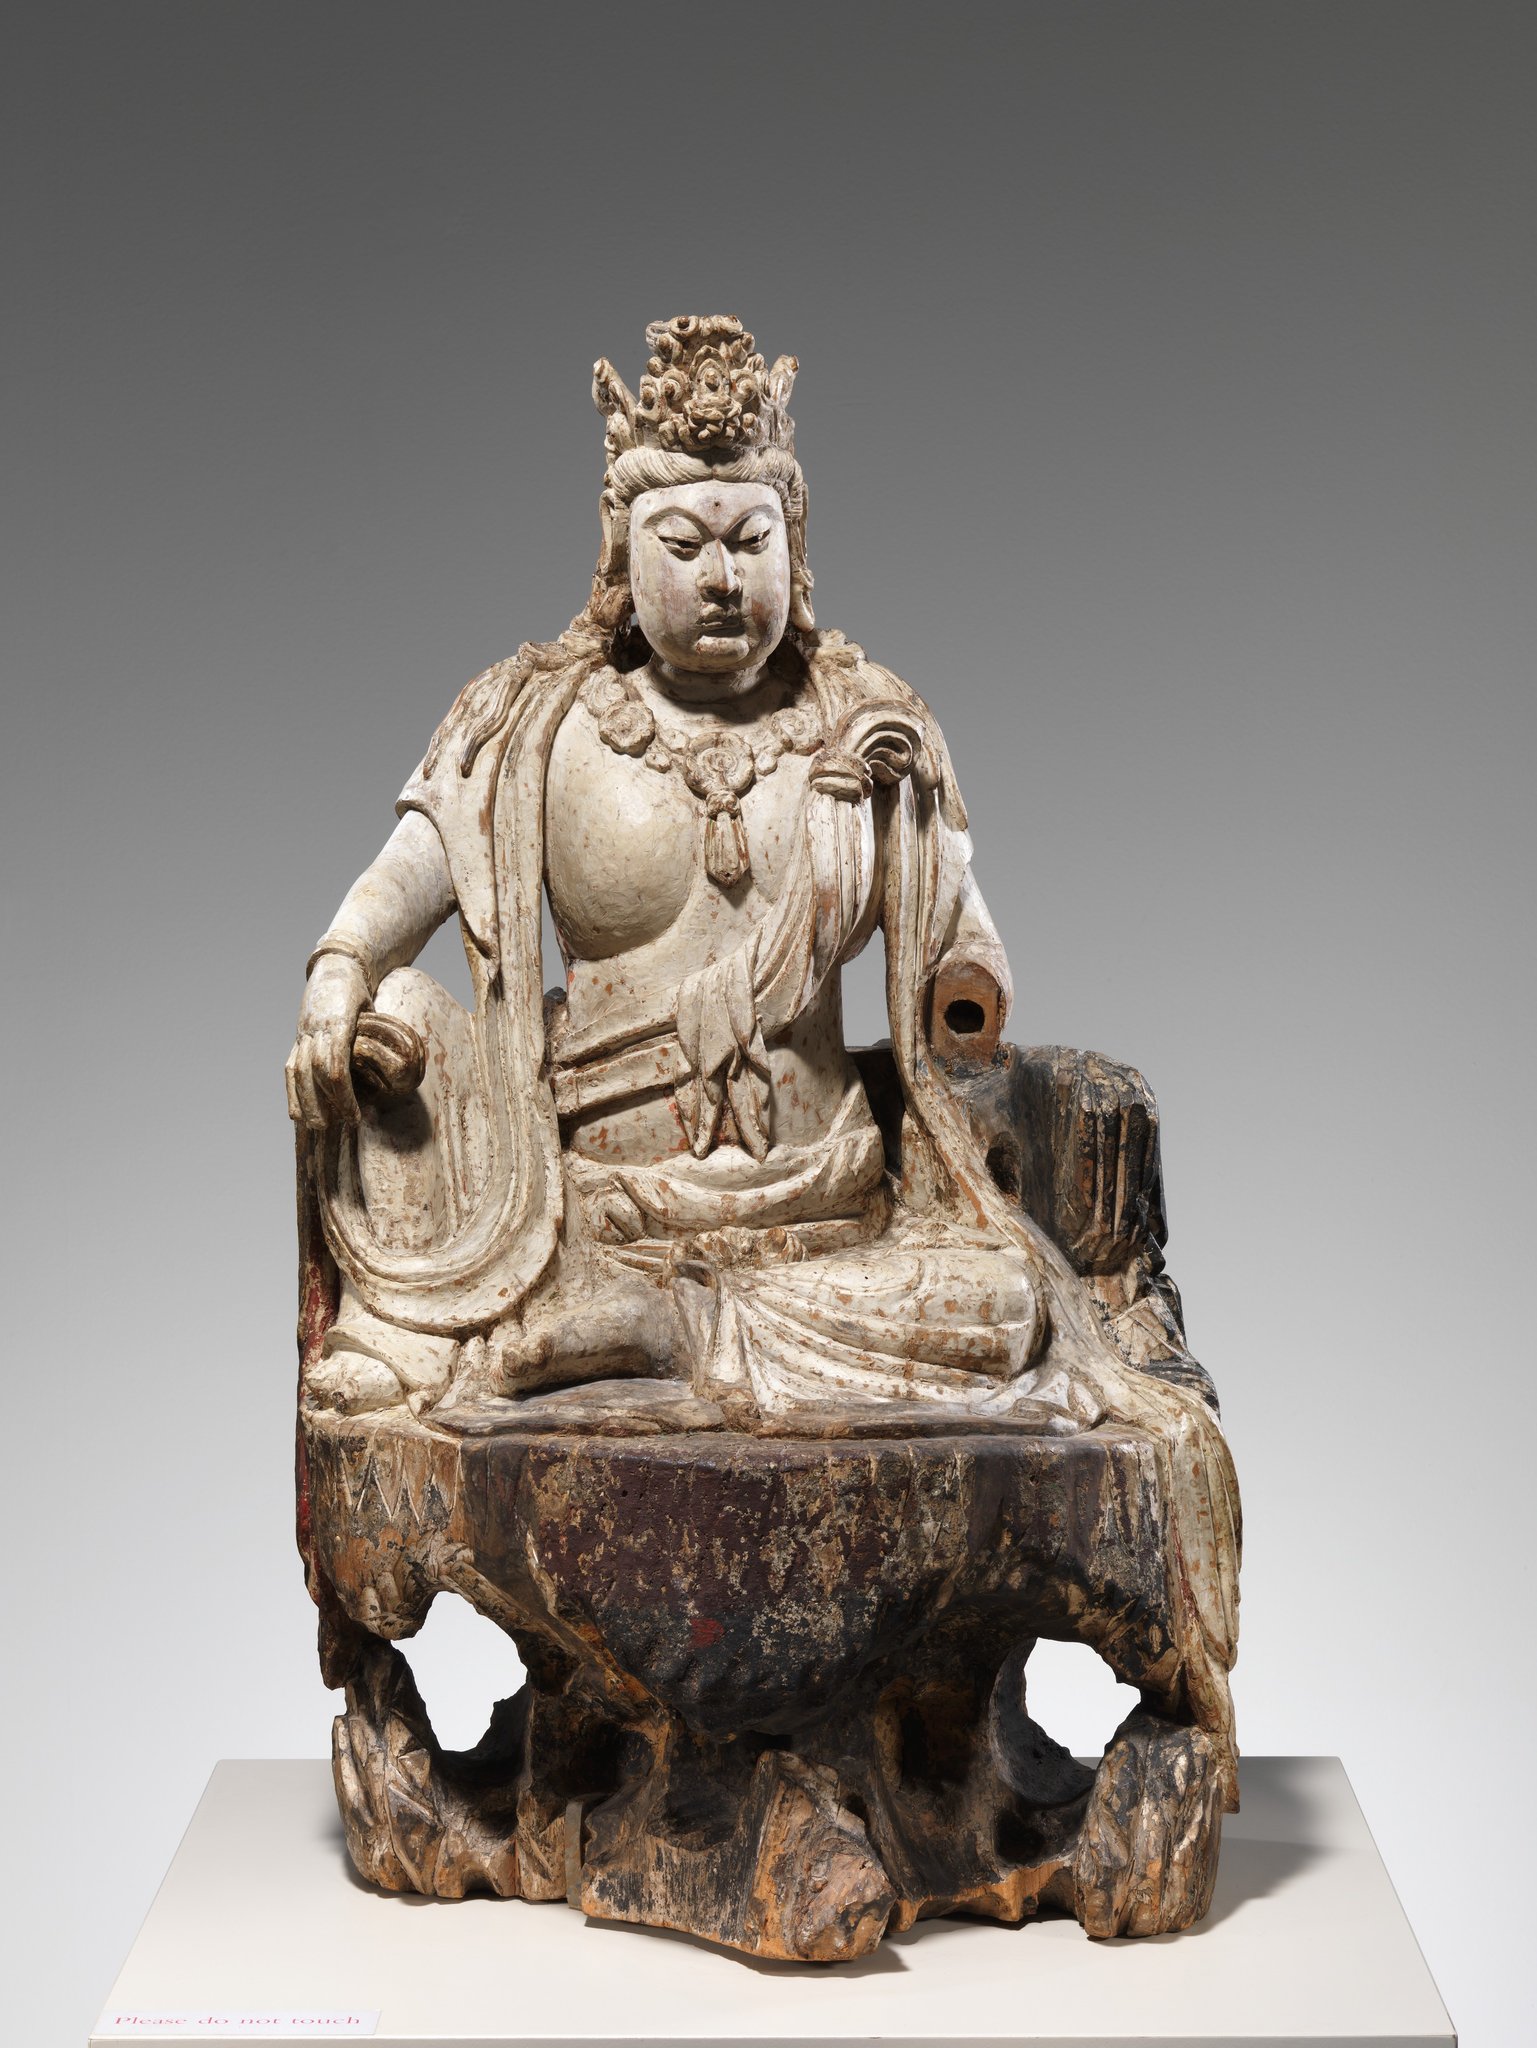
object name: figure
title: Bodhisattva Avalokiteshvara in Water Moon Form (Shuiyue Guanyin)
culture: chinese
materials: gesso, pigment, wood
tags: buddhism,avalokiteshvara,bodhisattvas